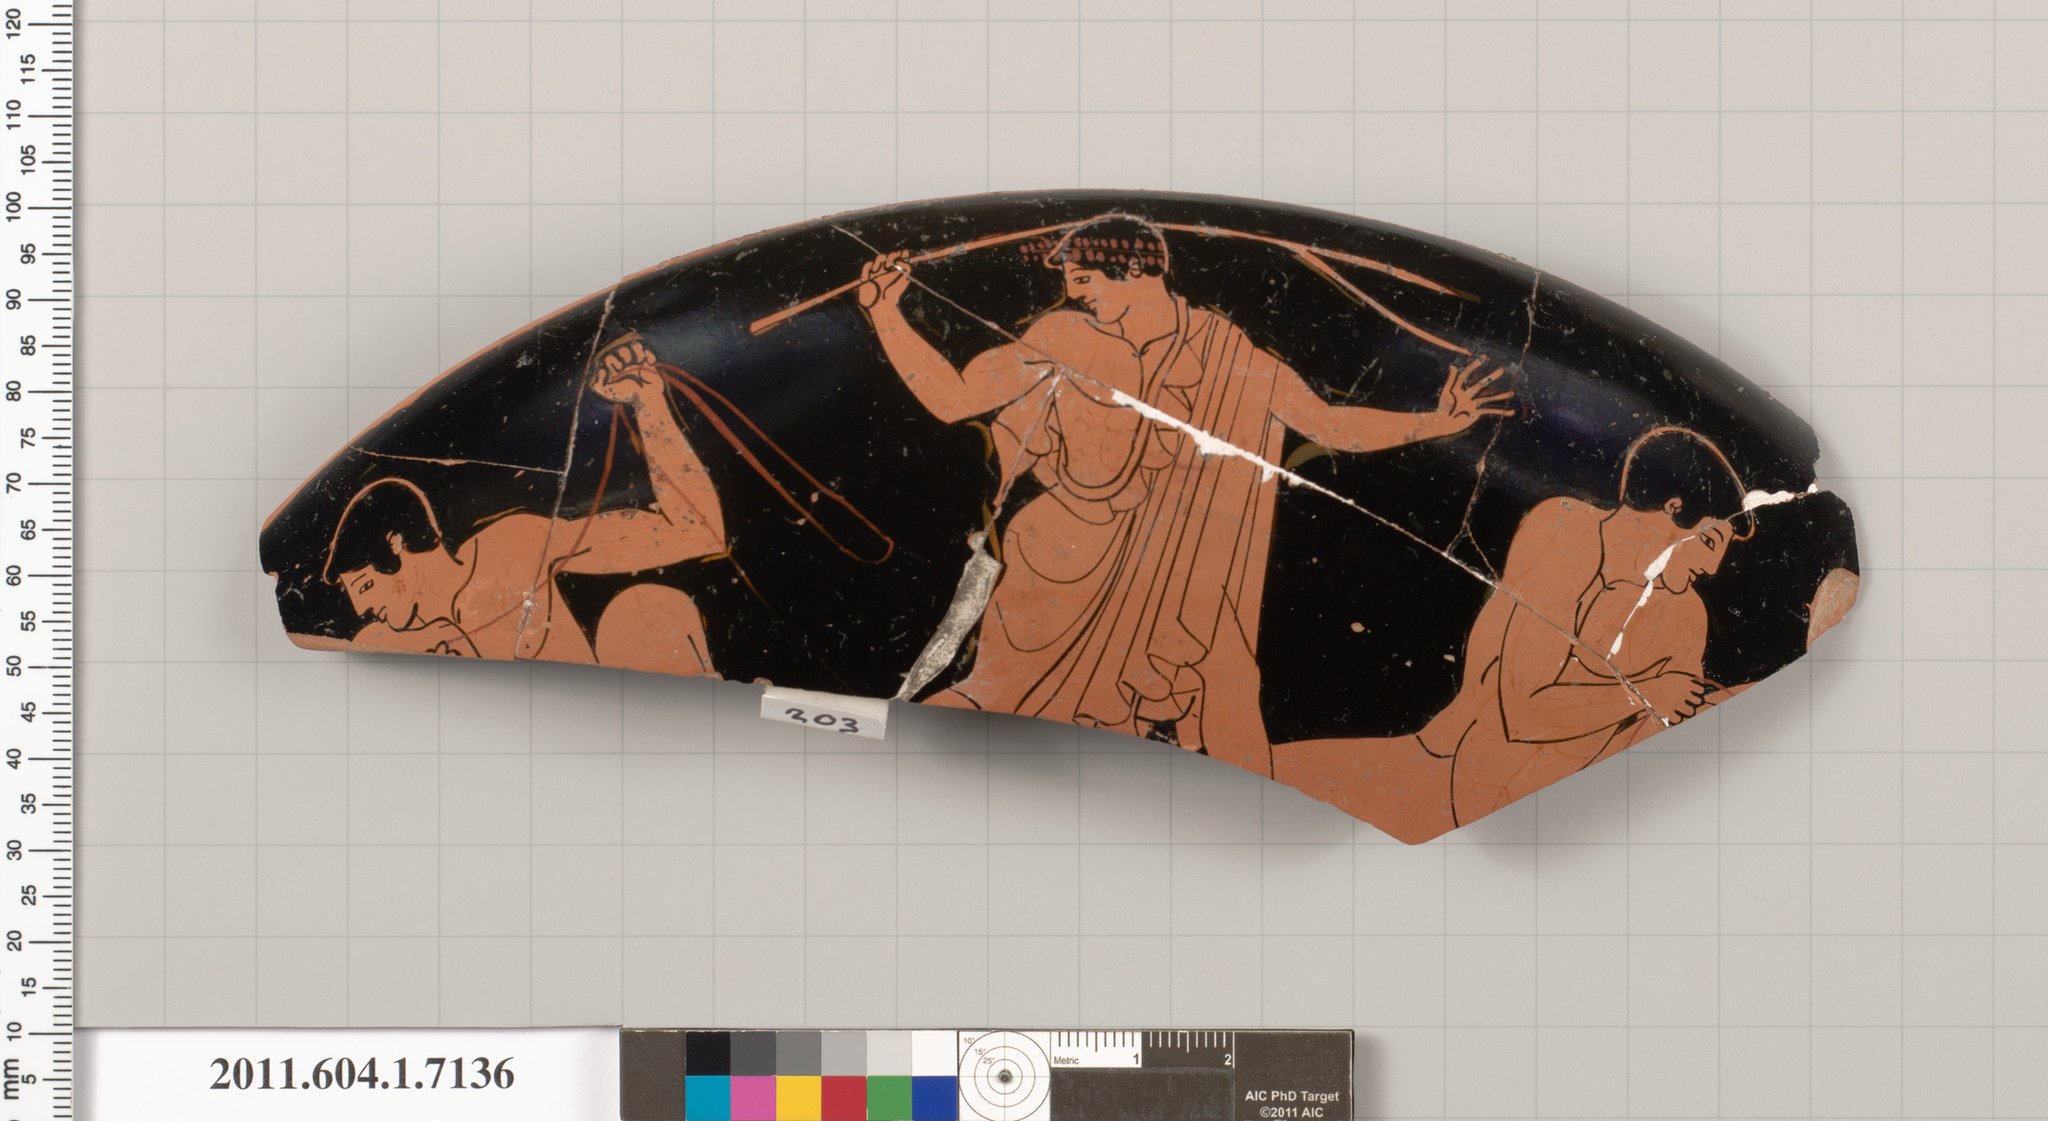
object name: kylix fragment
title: Terracotta fragment of a kylix (drinking cup)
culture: greek, attic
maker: makron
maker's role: artist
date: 500-480 BCE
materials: terracotta